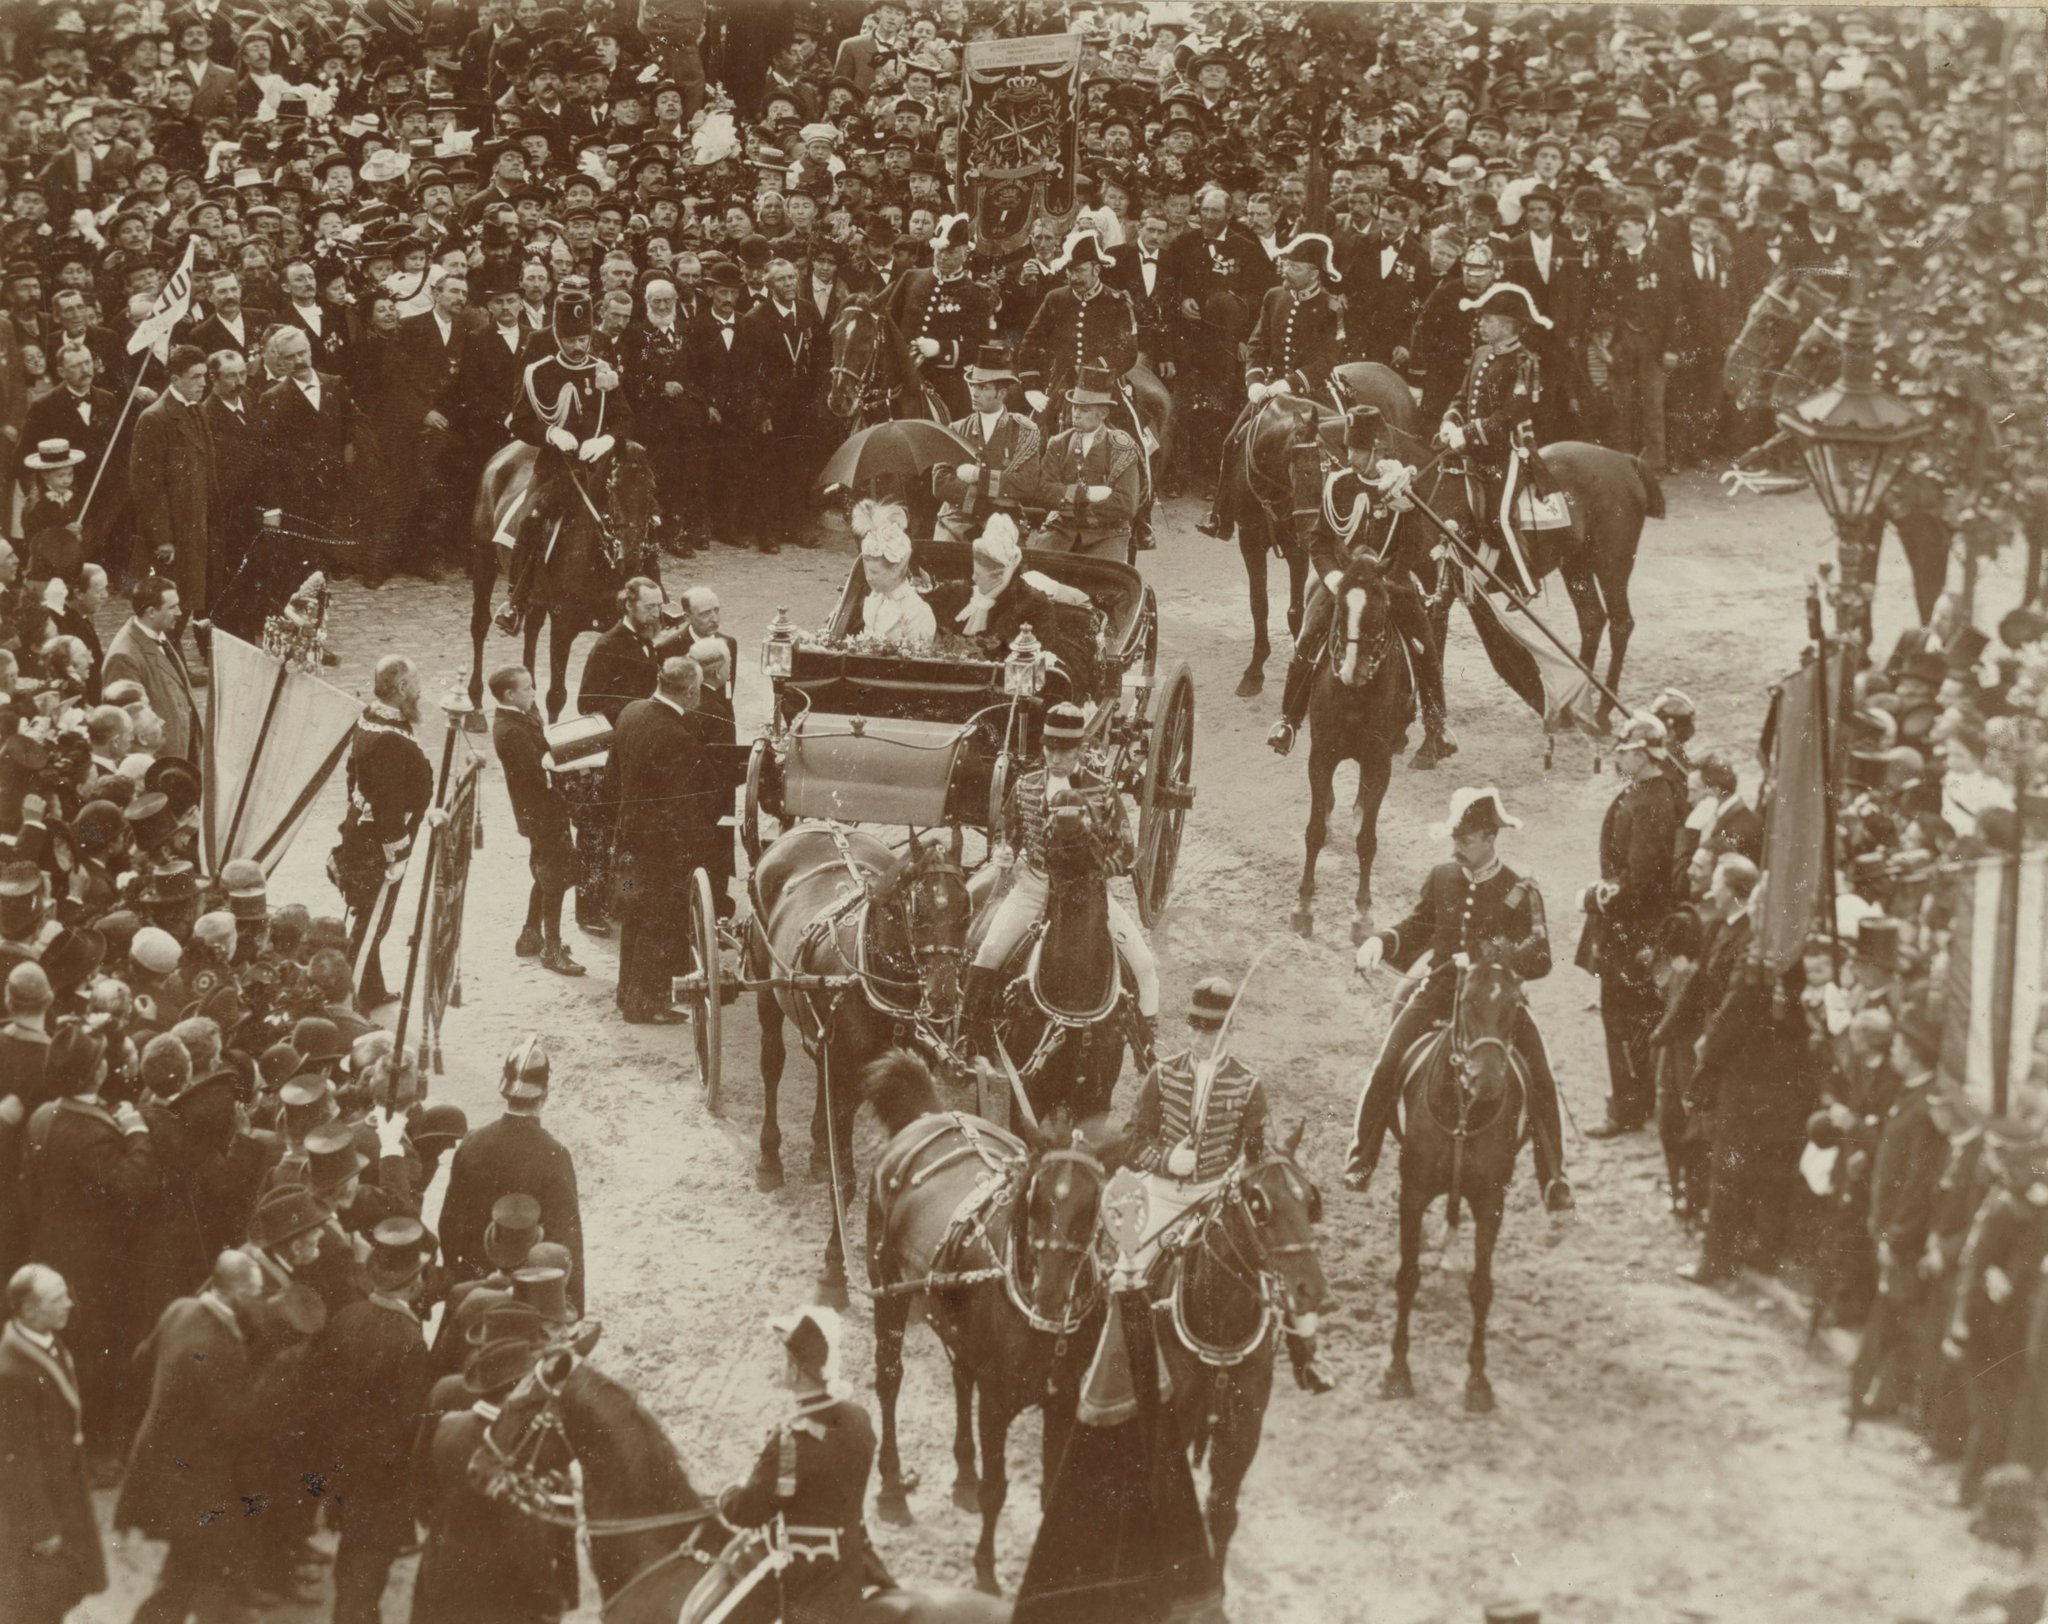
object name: photograph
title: Rijtoer door Rotterdam van Koningin Wilhelmina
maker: willem ganter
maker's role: fotograaf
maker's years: 1849-1908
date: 1899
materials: cardboard, photographic support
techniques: albumen print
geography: rotterdam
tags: the hague, print maker, wilhelmina of the netherlands, emma (queen consort of the netherlands), rotterdam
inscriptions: name: ‘L.M. Lammerse kantoor boekhandel no 41 Hoofdsteeg, Rotterdam’, name: ‘W. Ganter, hof-photograaf Jonkerfransstraat 120, Rotterdam’, inscription: ‘... in Rotterdam’